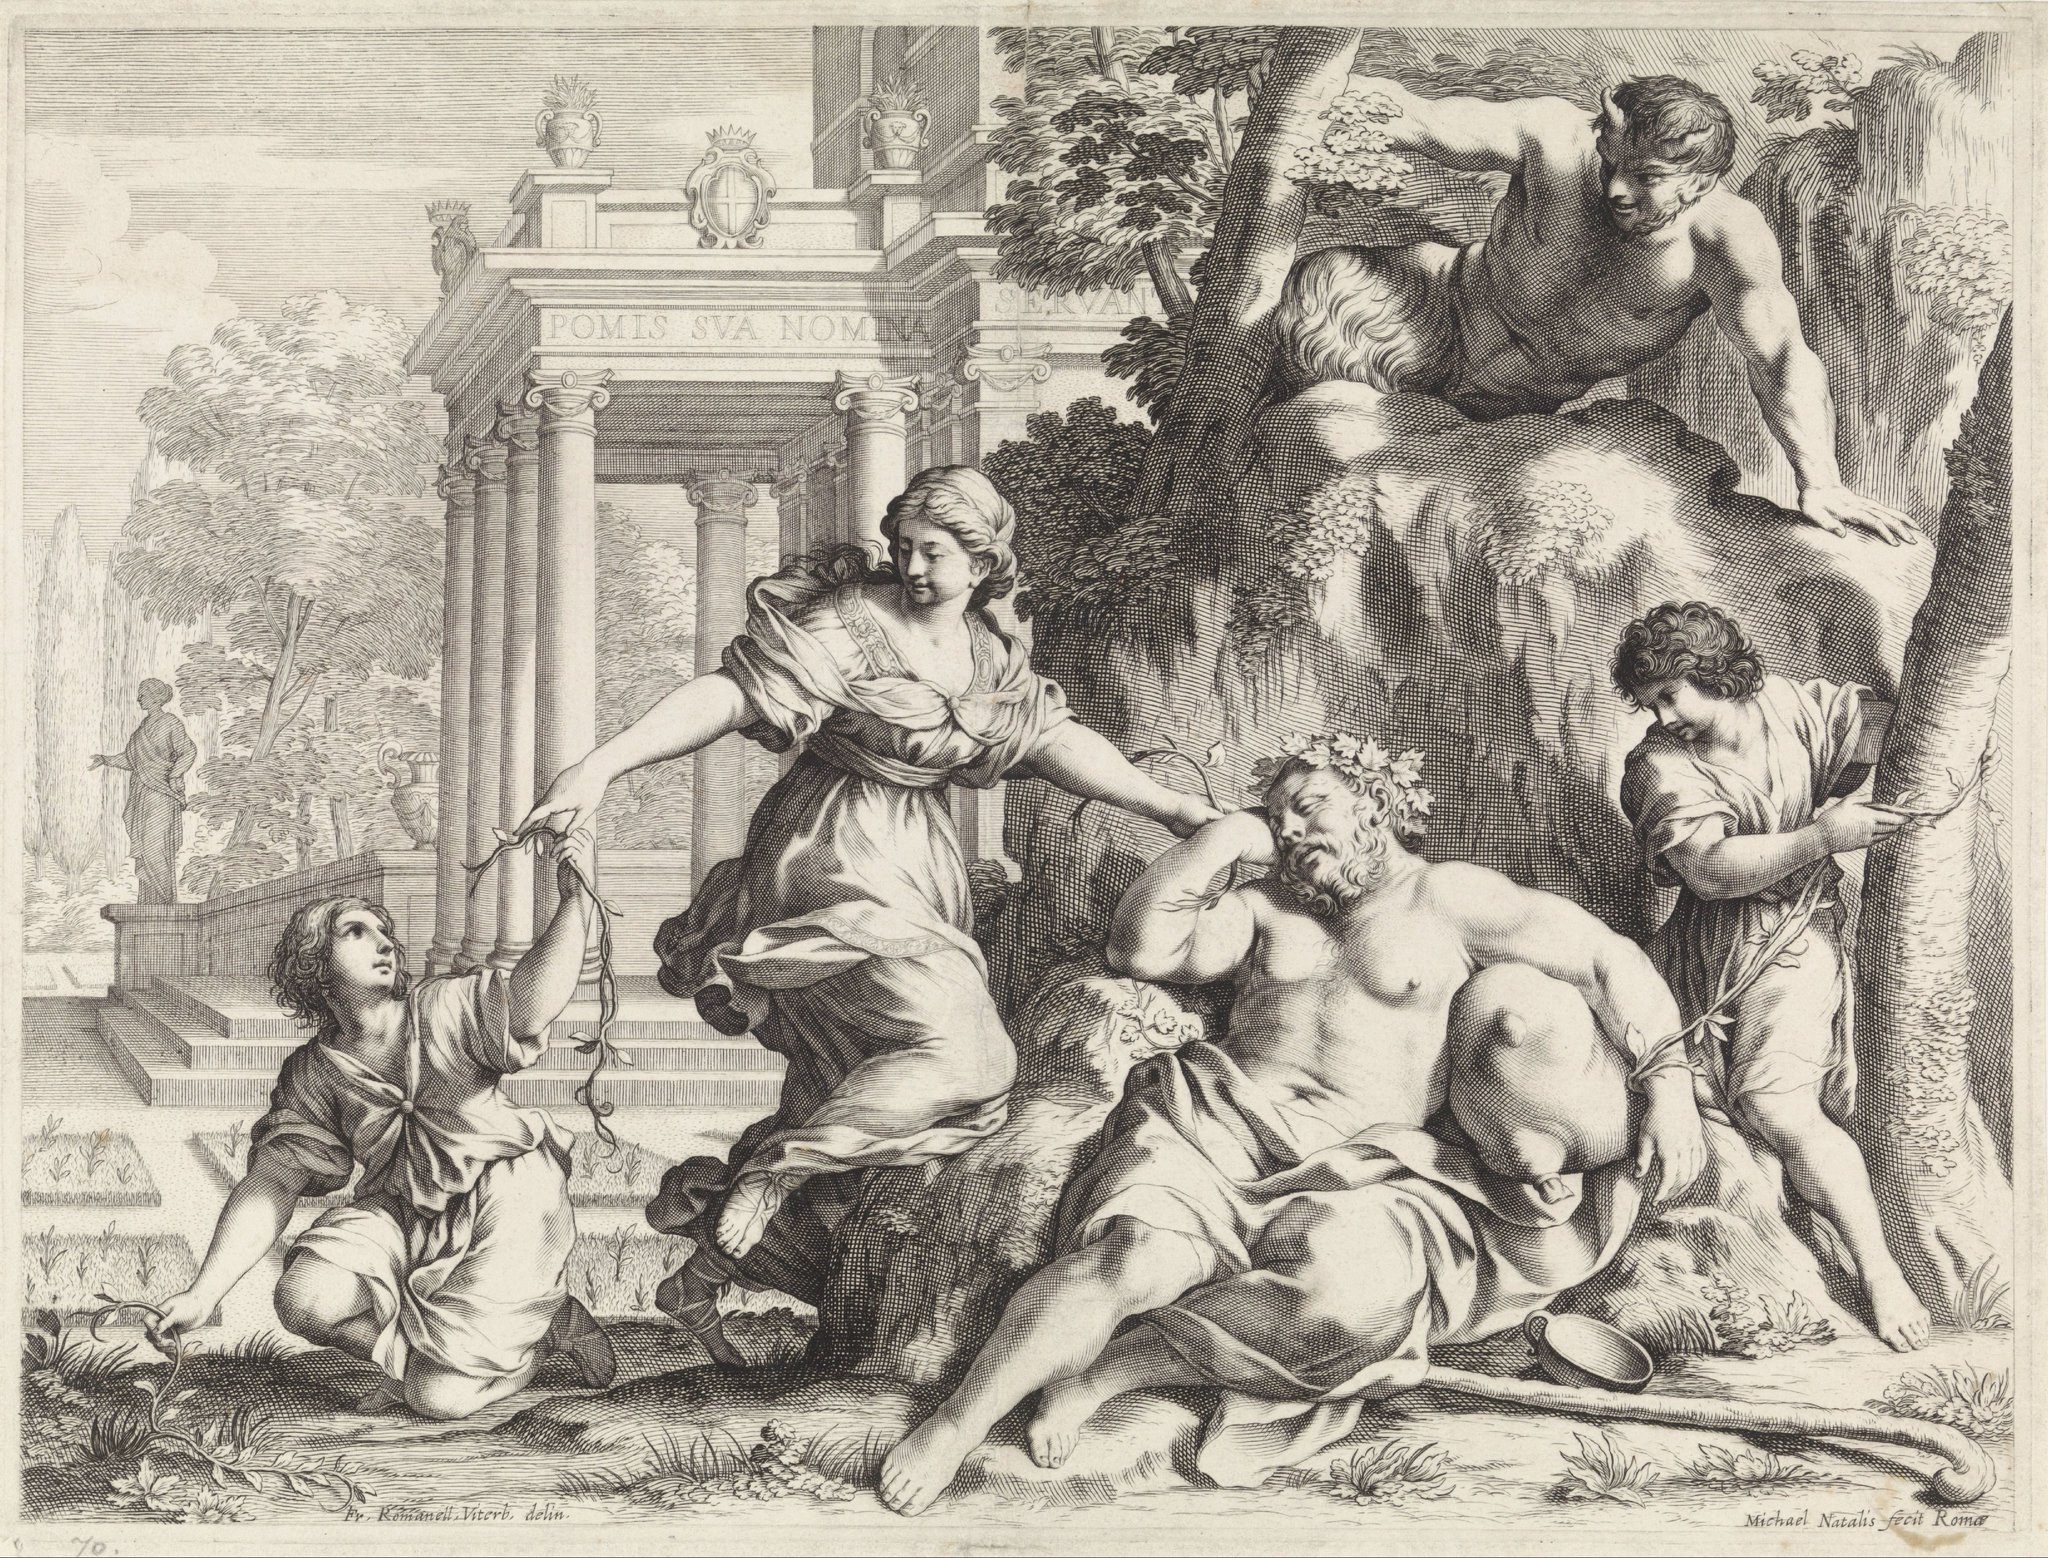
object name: print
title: Slapende Silenus vastgebonden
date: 1632-1633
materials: paper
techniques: engraving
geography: rome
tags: (story of) silenus, sleeping; unconsciousness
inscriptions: collector's mark: Lugt 240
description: De slapende Silenus, een kroon van wingerdbladeren op het hoofd, wordt door drie volgelingen van Bacchus met twijgen aan een boom vastgebonden. Naast Silenus liggen zijn drinknap en staf. Boven, op een rots, kijkt een sater toe. Linksachter de galerij van een klassieke tempel met het standbeeld van een vrouw ervoor.